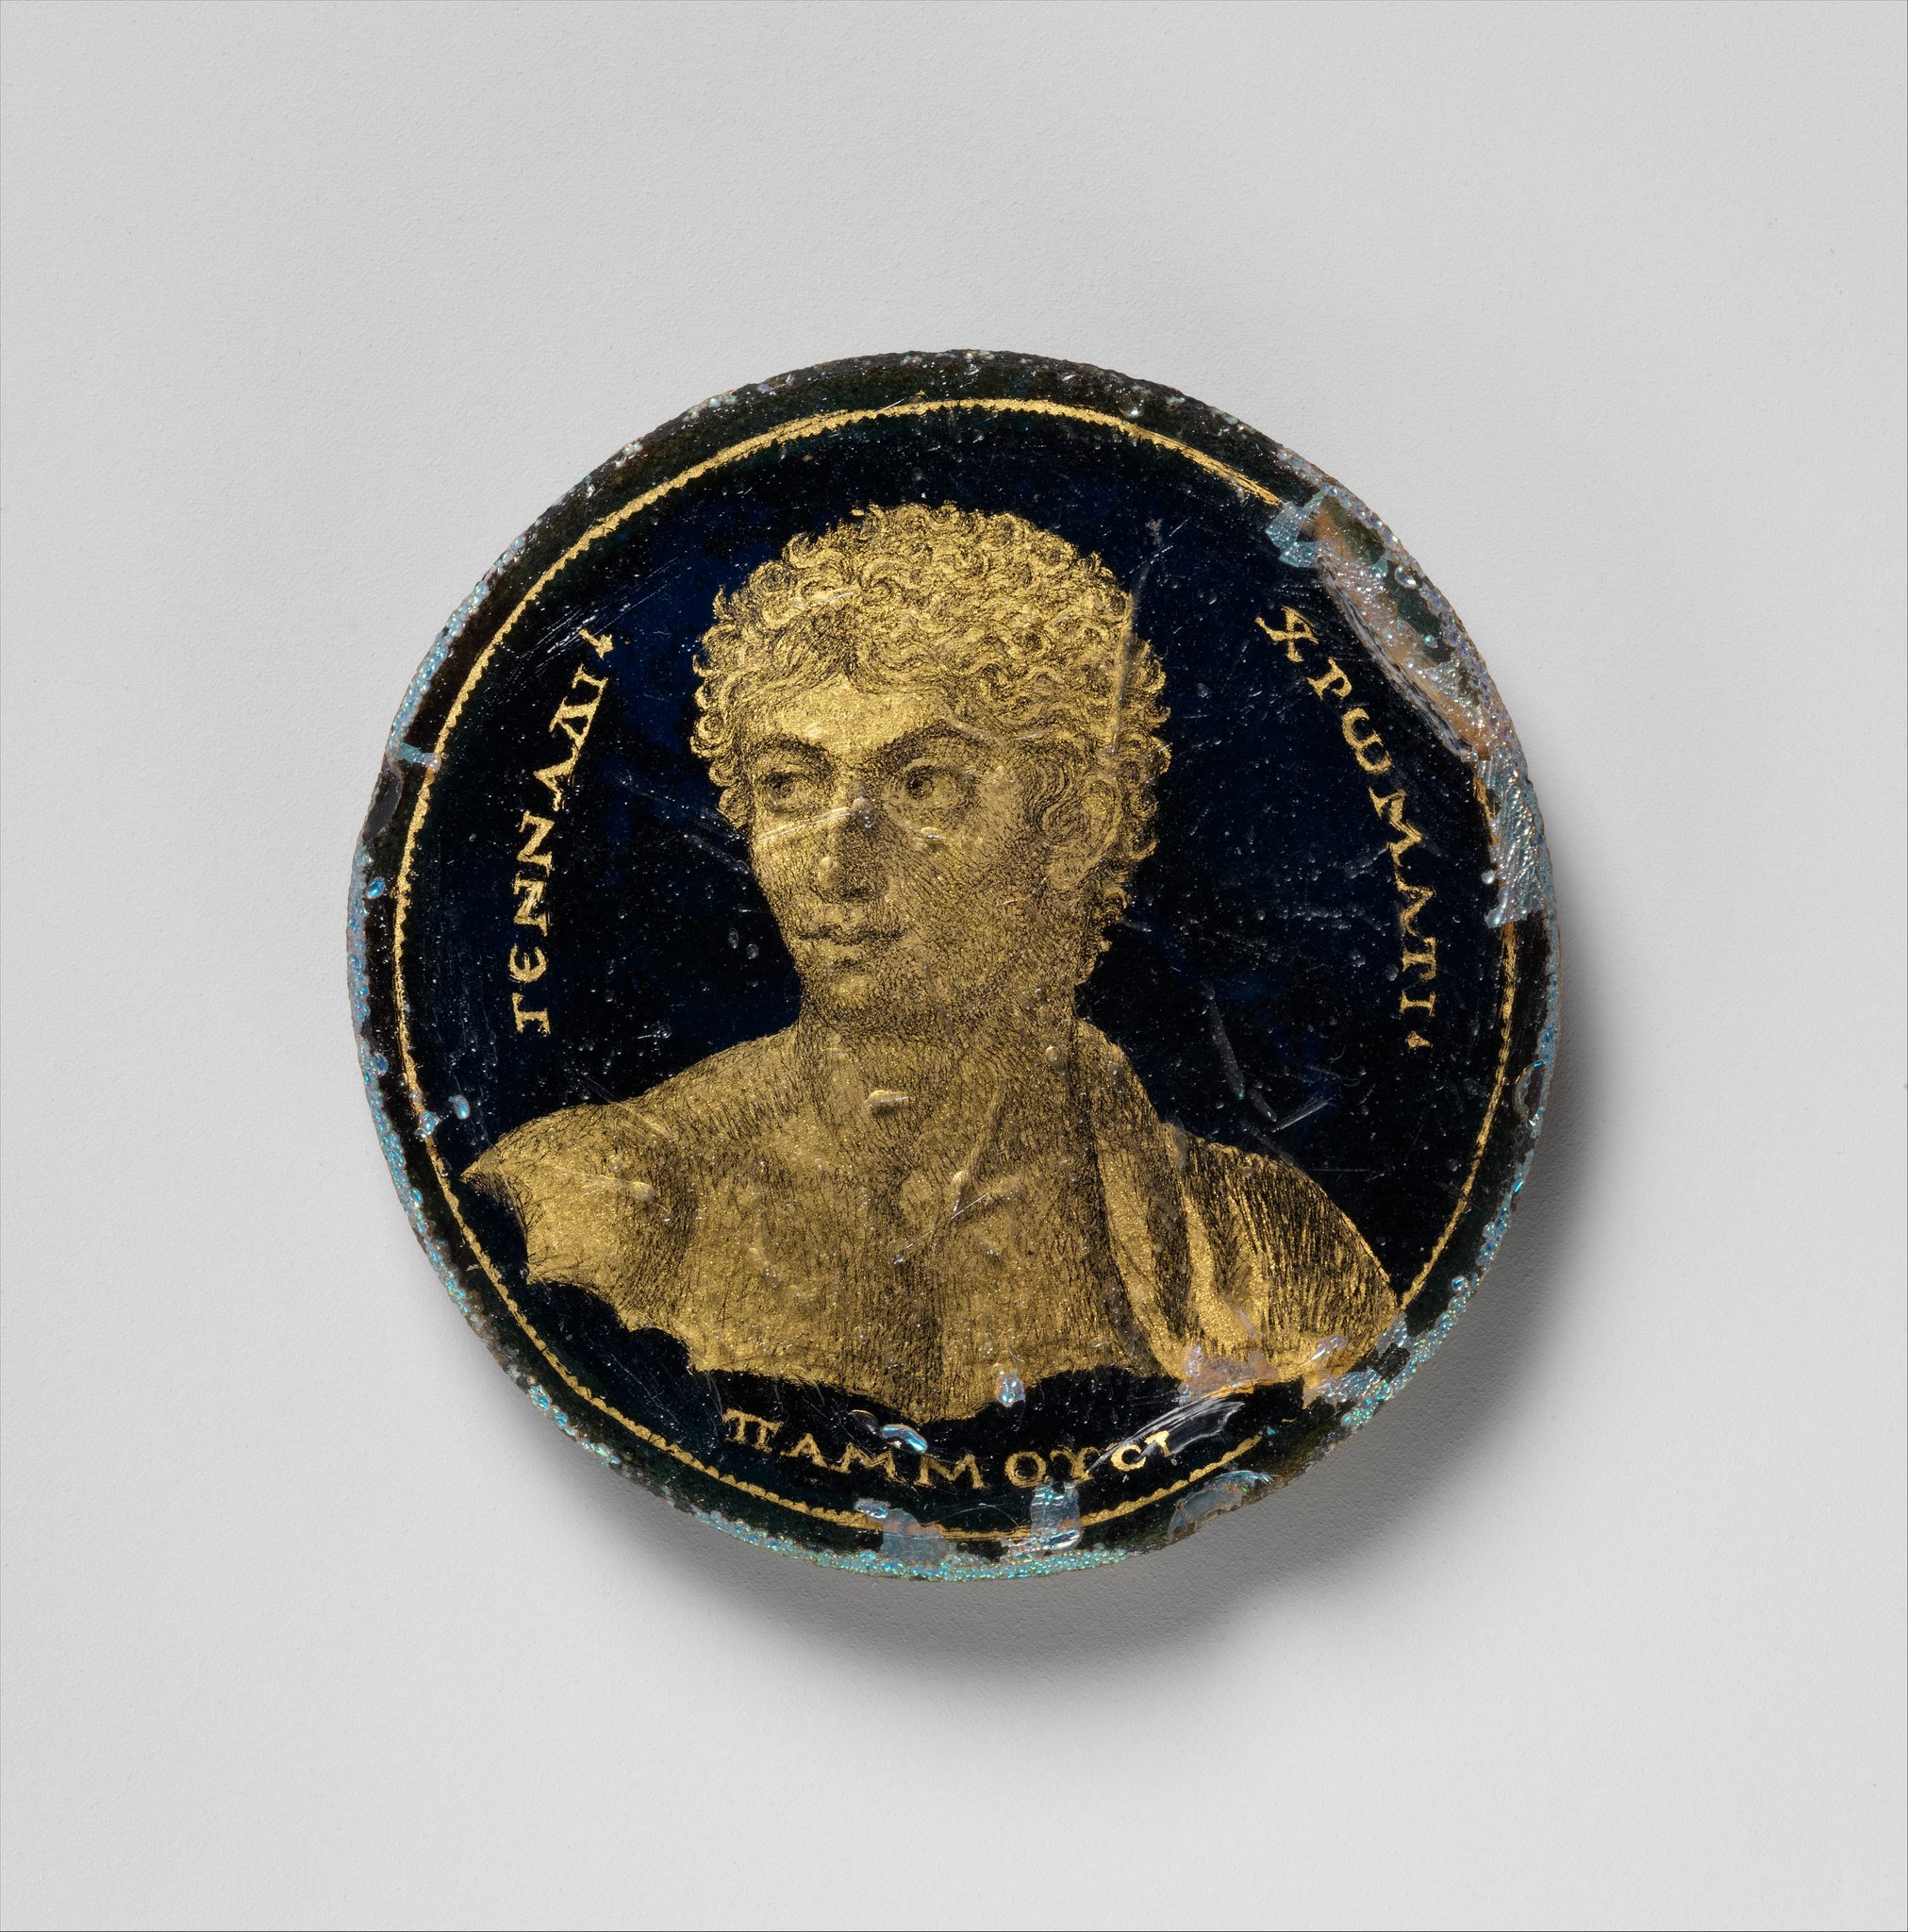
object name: medallion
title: Medallion with a Portrait of Gennadios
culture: roman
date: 250-300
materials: glass, gold leaf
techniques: polychromy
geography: egypt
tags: men,portraits